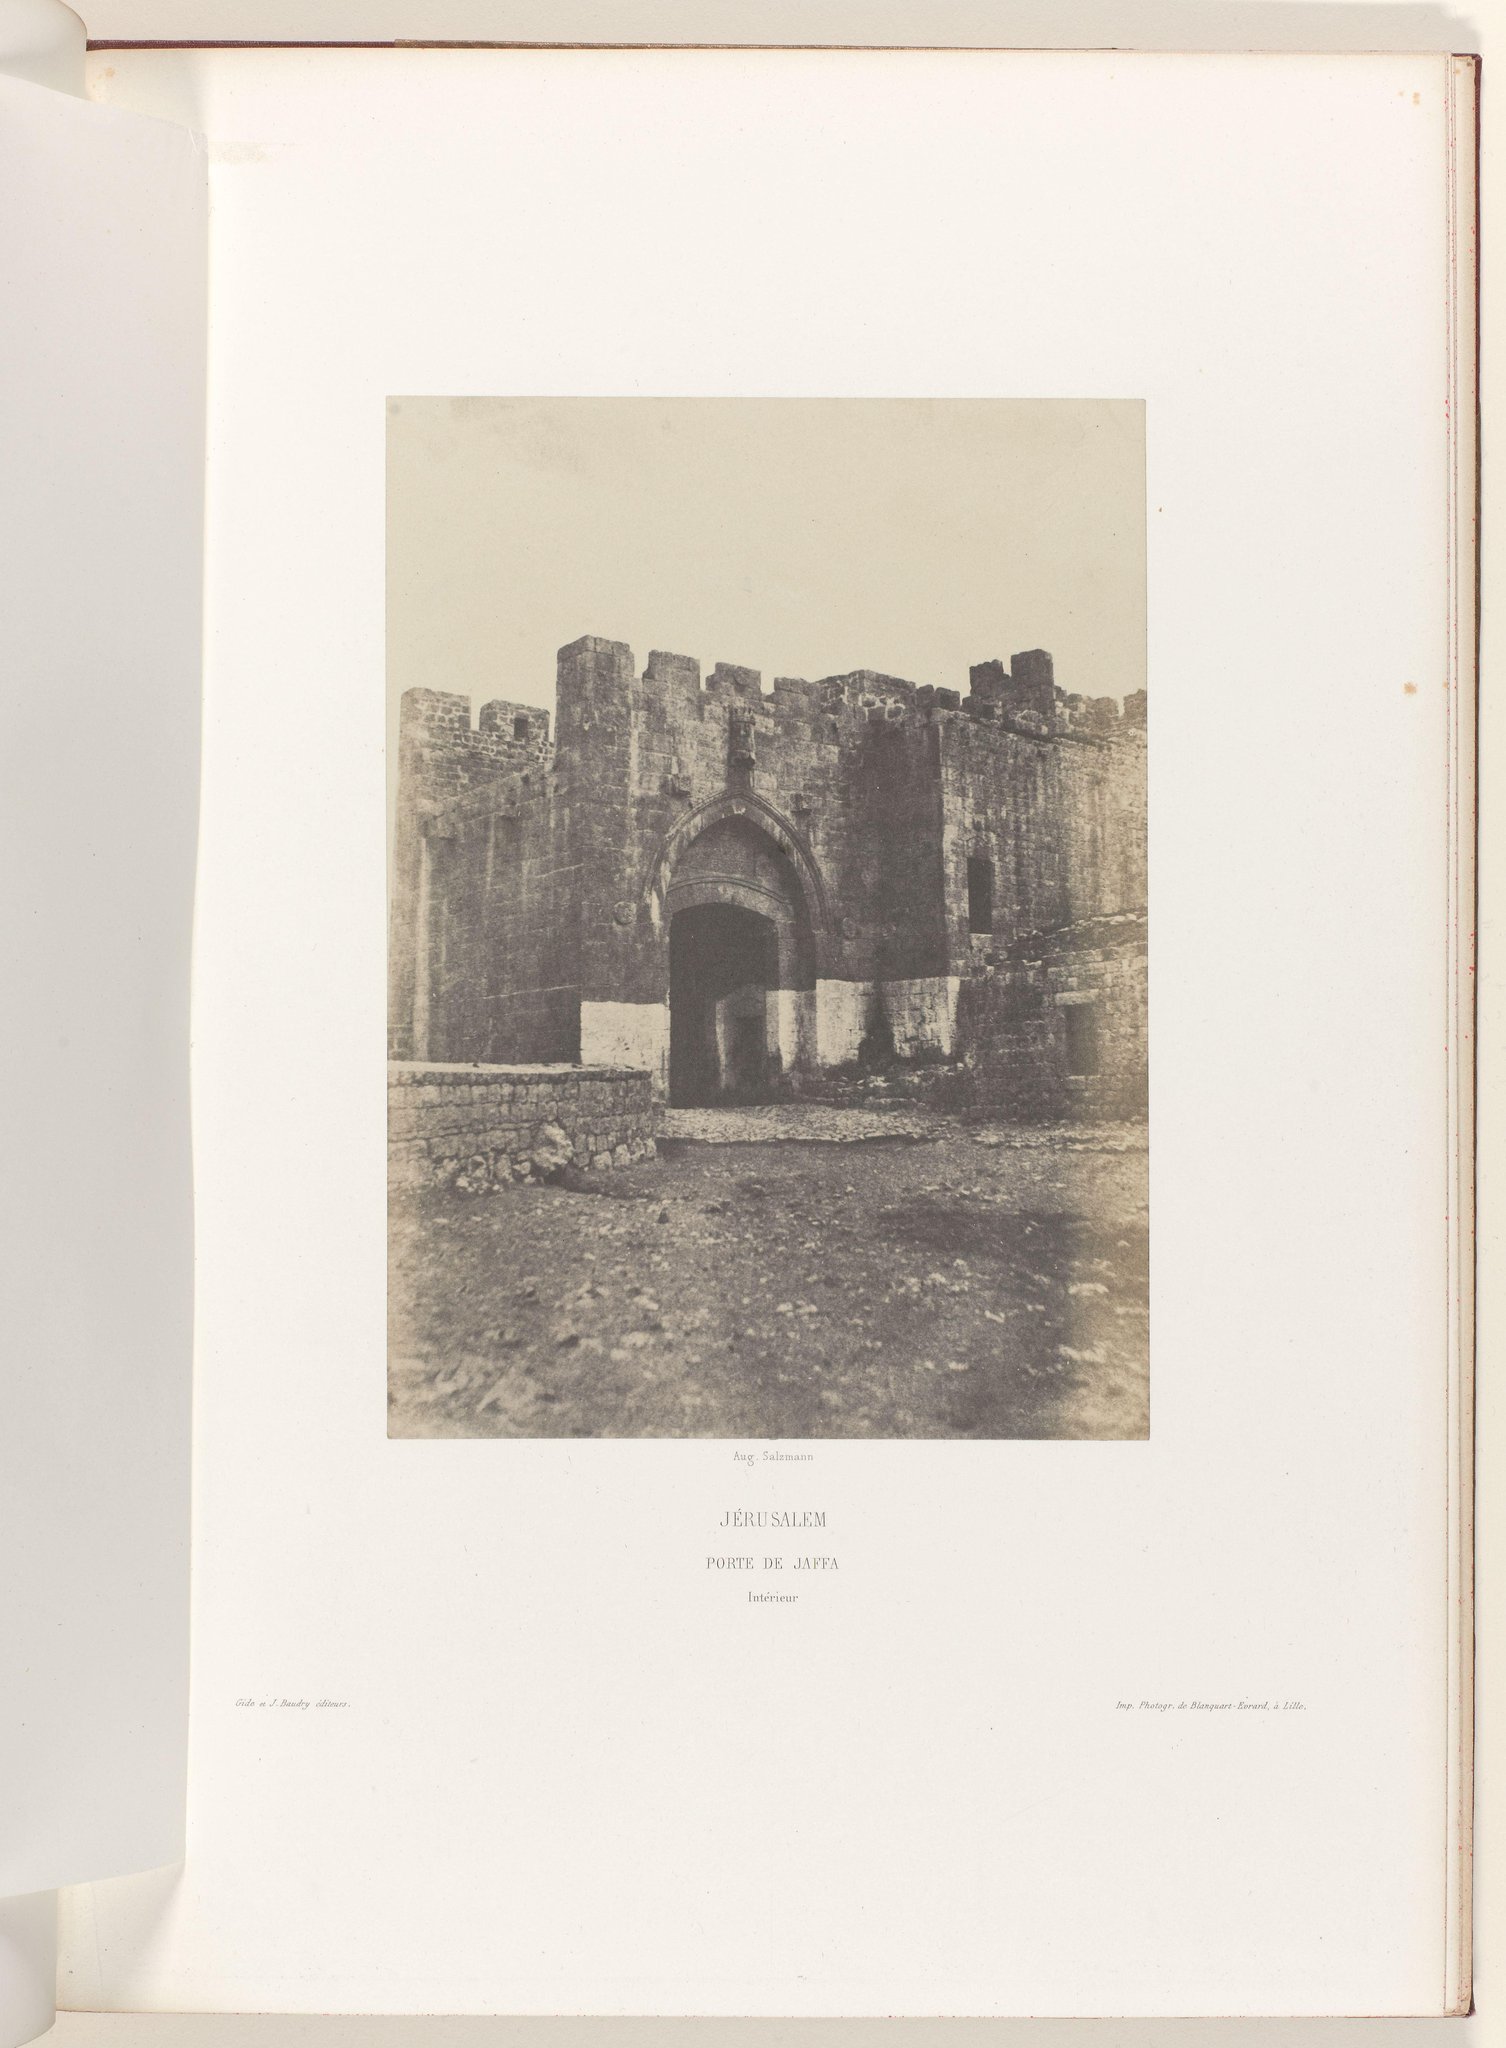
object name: photograph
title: Jérusalem. Porte de Jaffa. Intérieur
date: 1854-1856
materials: cardboard, paper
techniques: salted paper print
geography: paris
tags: gate, entrance, city-gate